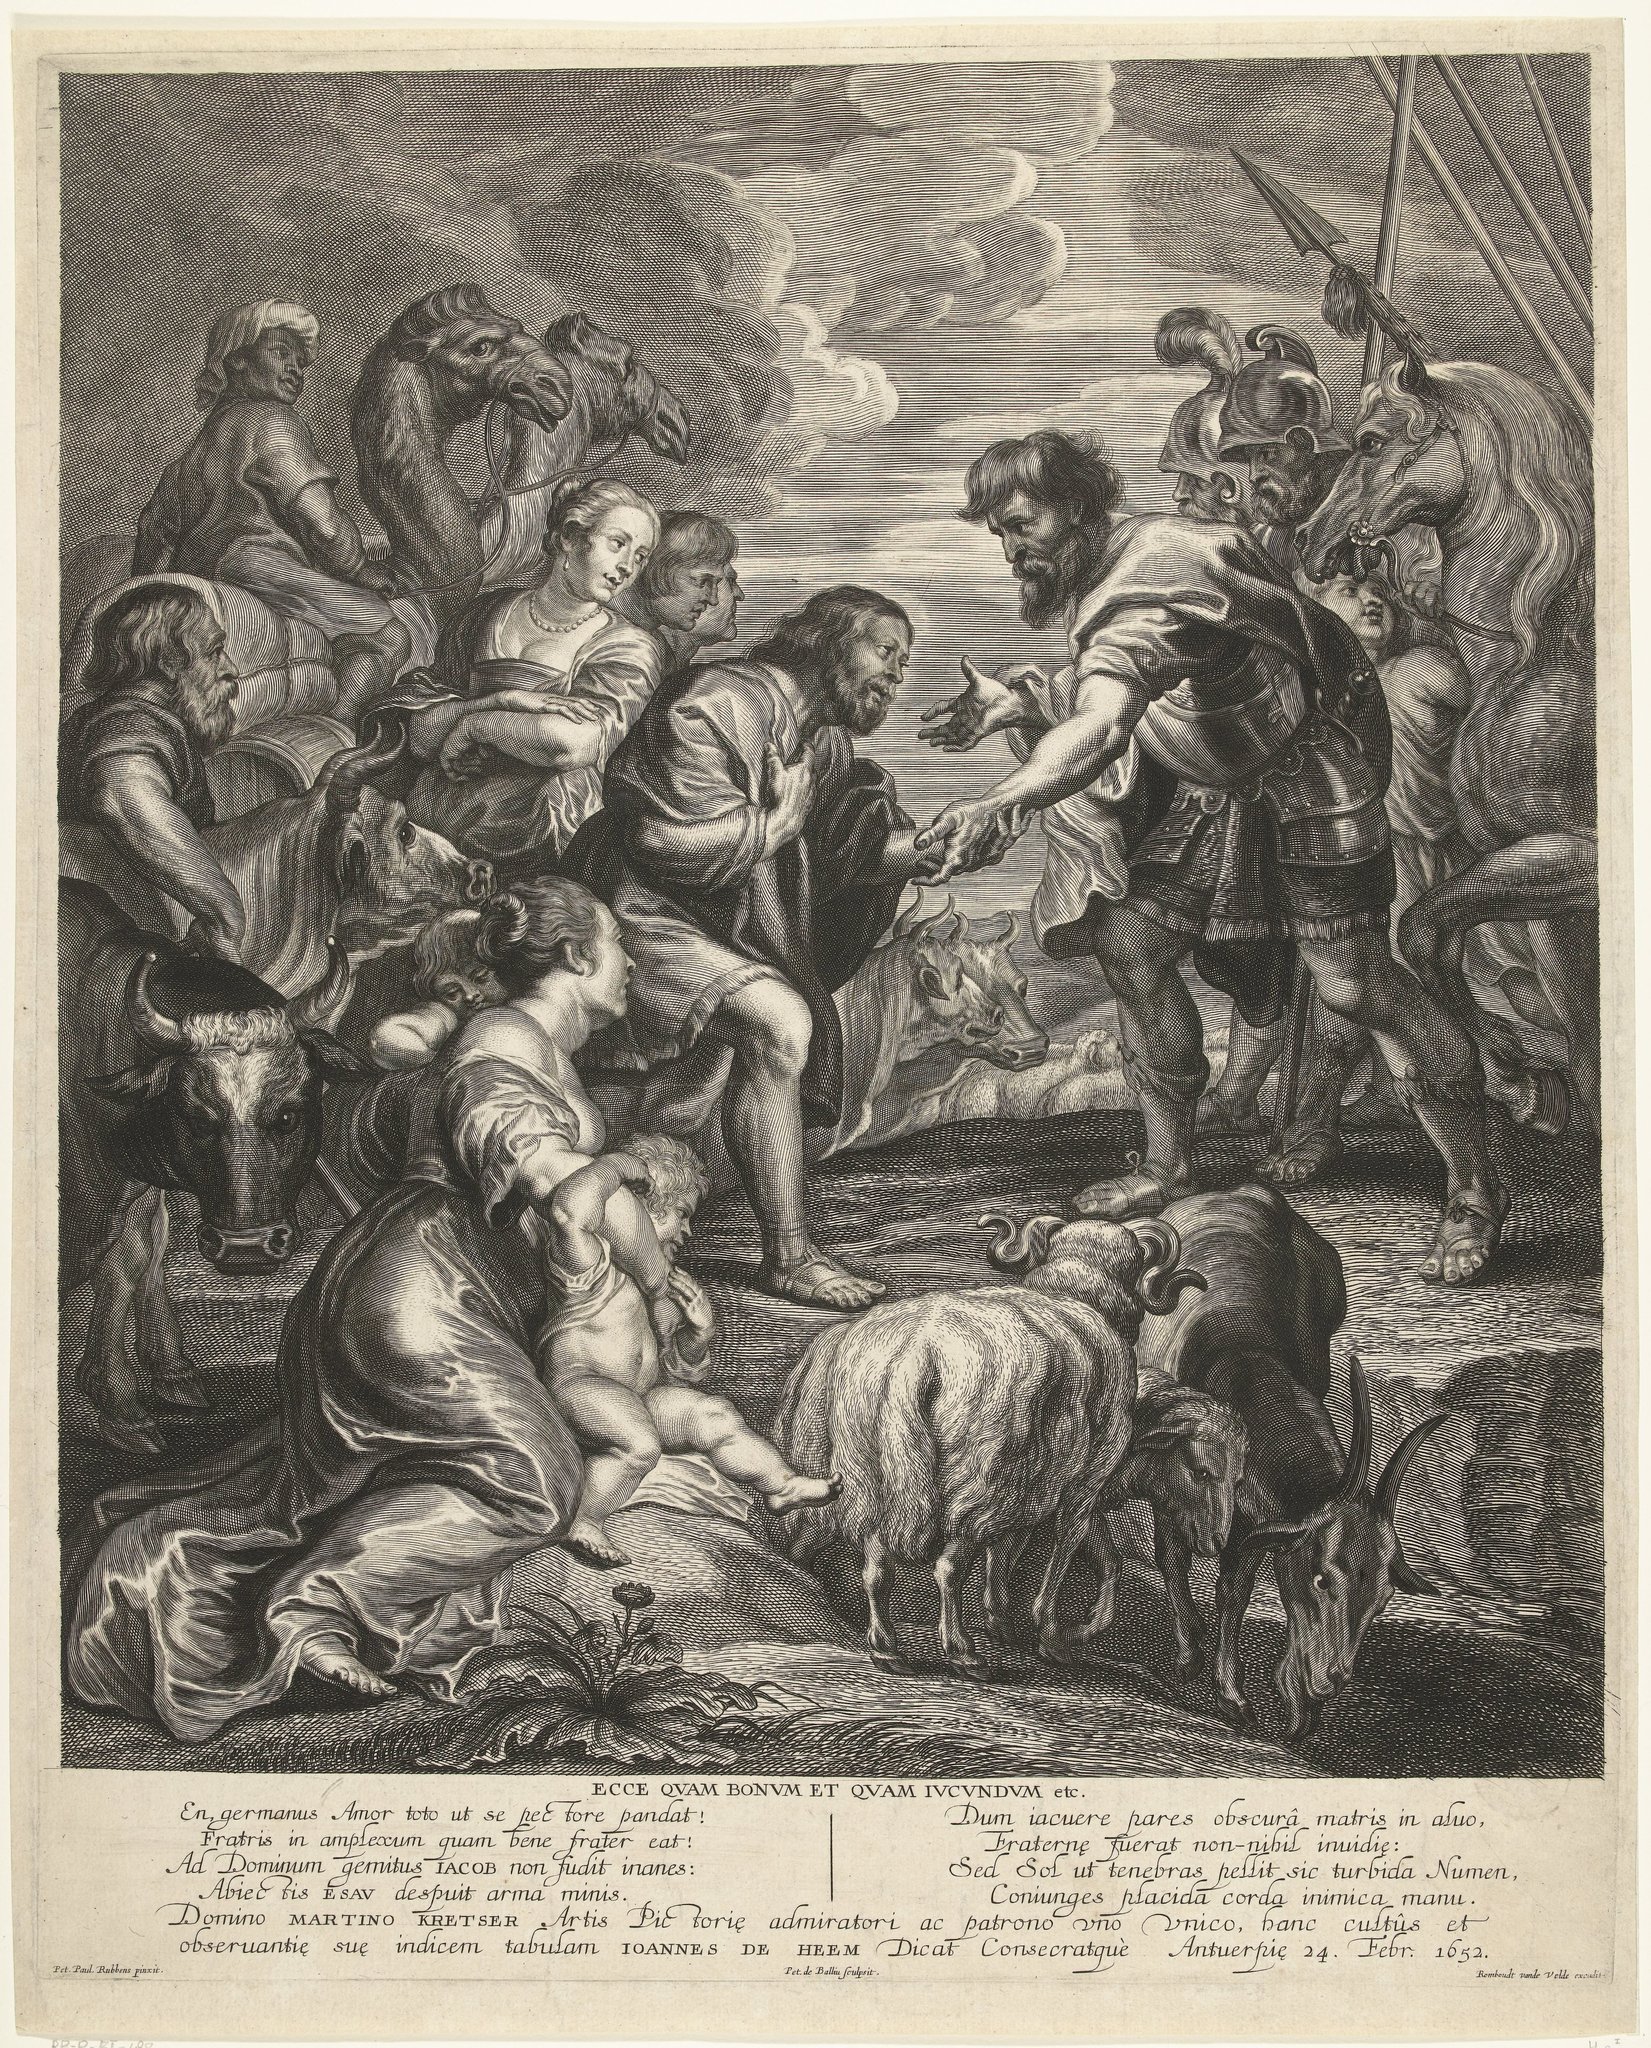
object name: print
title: Verzoening van Jakob en Esau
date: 1623-1660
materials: paper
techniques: engraving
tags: the meeting between esau and jacob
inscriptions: collector's mark: Lugt 240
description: De broers Jakob en Esau vallen elkaar in de armen. Rechts, achter Esau staat zijn leger. Links de geknielde vrouwen, kinderen en knechten van Jakob. Onder de voorstelling staan twee coupletten in het Latijn.